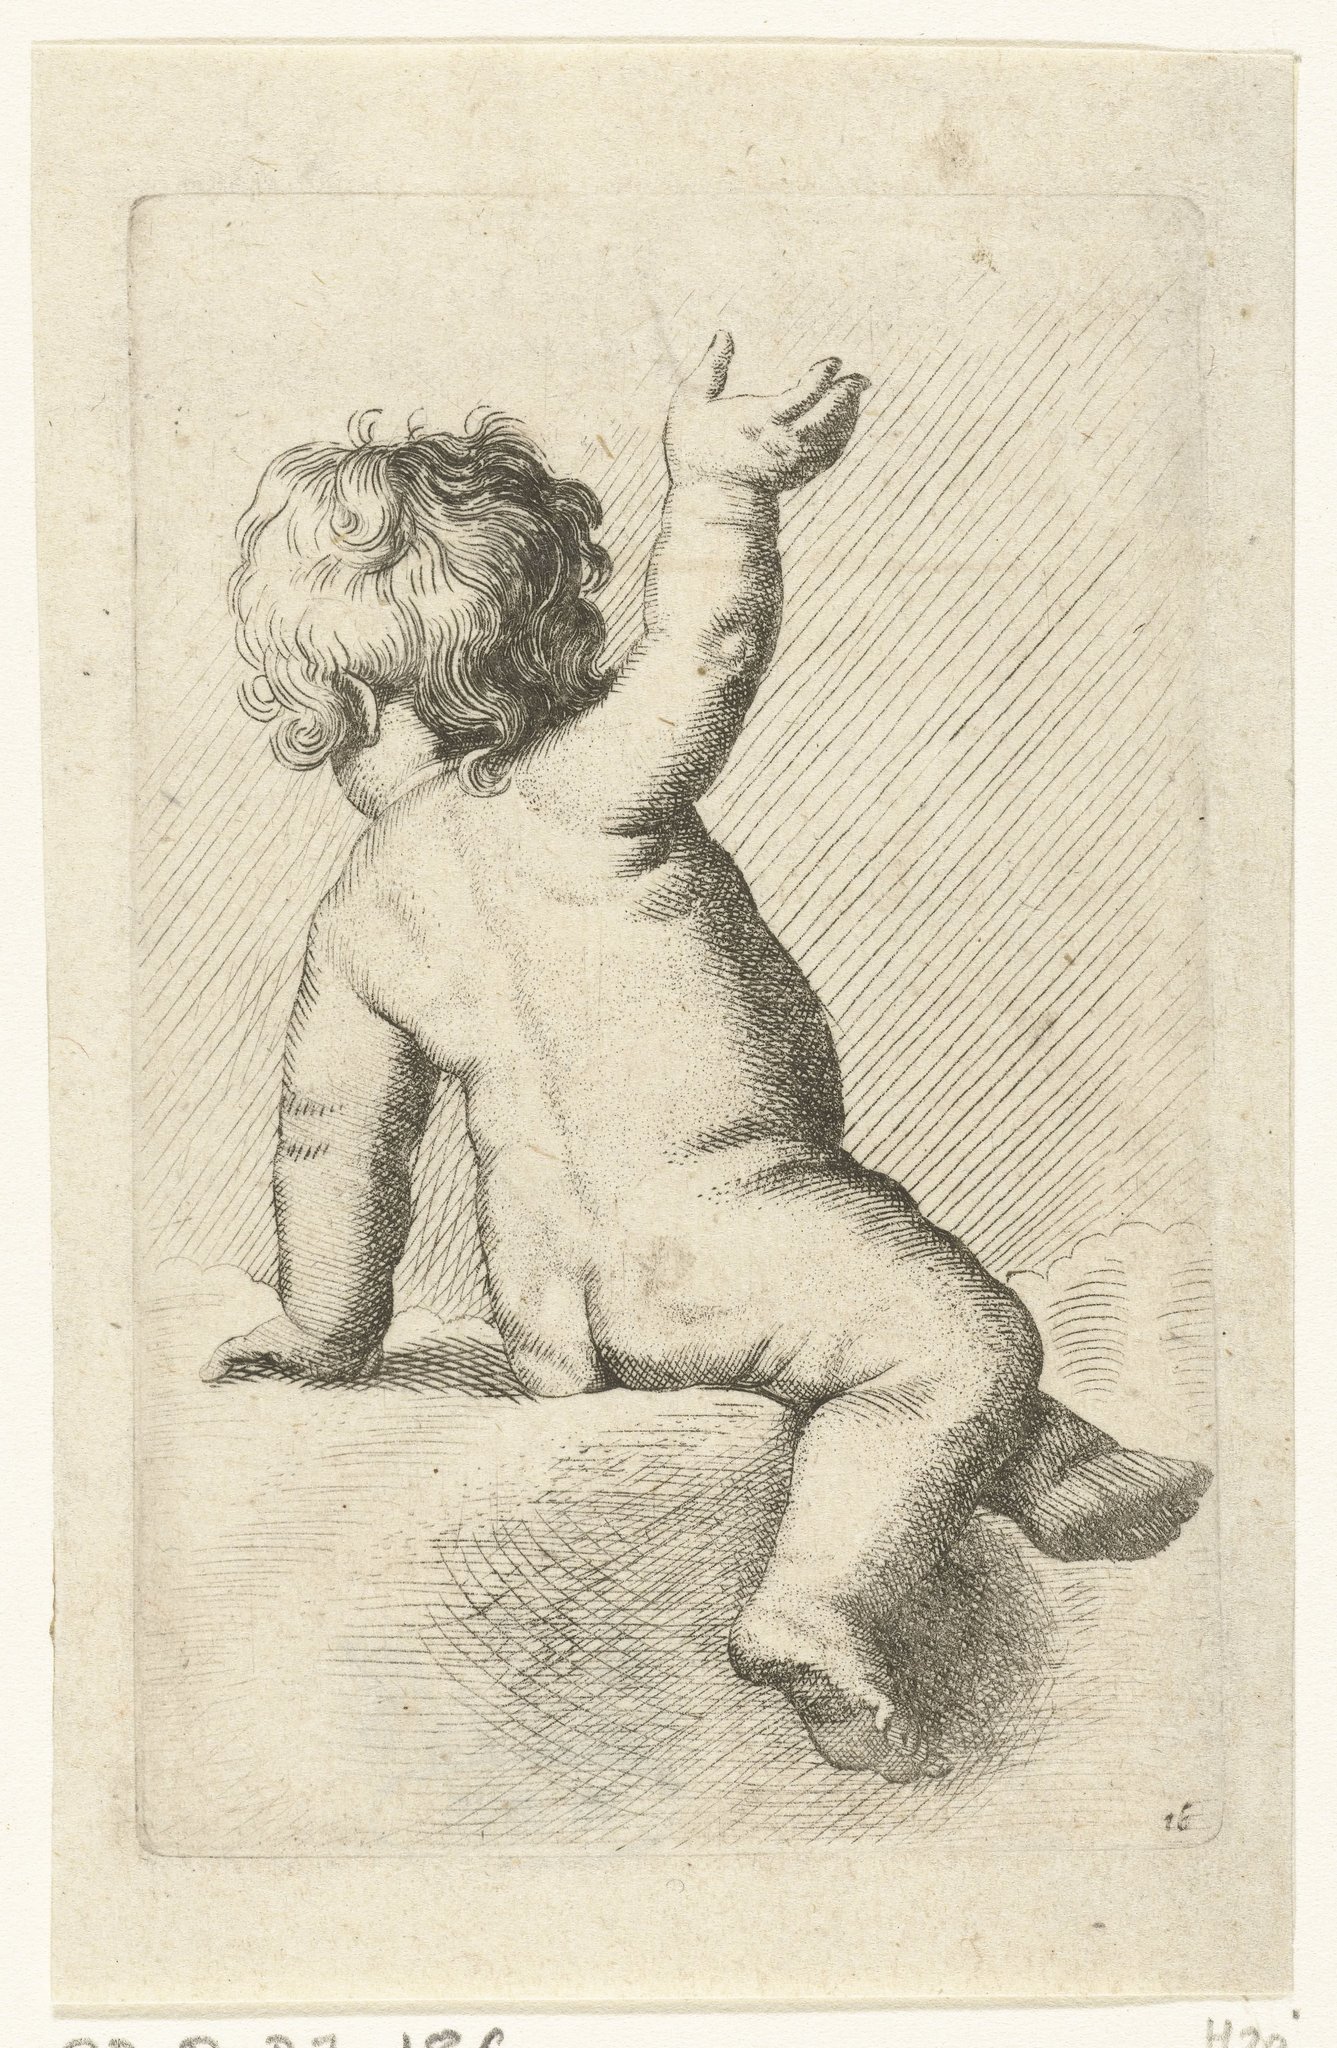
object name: print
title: Zittend kind van achteren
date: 1630-1652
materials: paper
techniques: engraving, etching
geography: amsterdam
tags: child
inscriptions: collector's mark: Lugt 2228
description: Zittend naakt kind van achteren. Prent uit een serie van 24 prenten met engelen of kinderen.